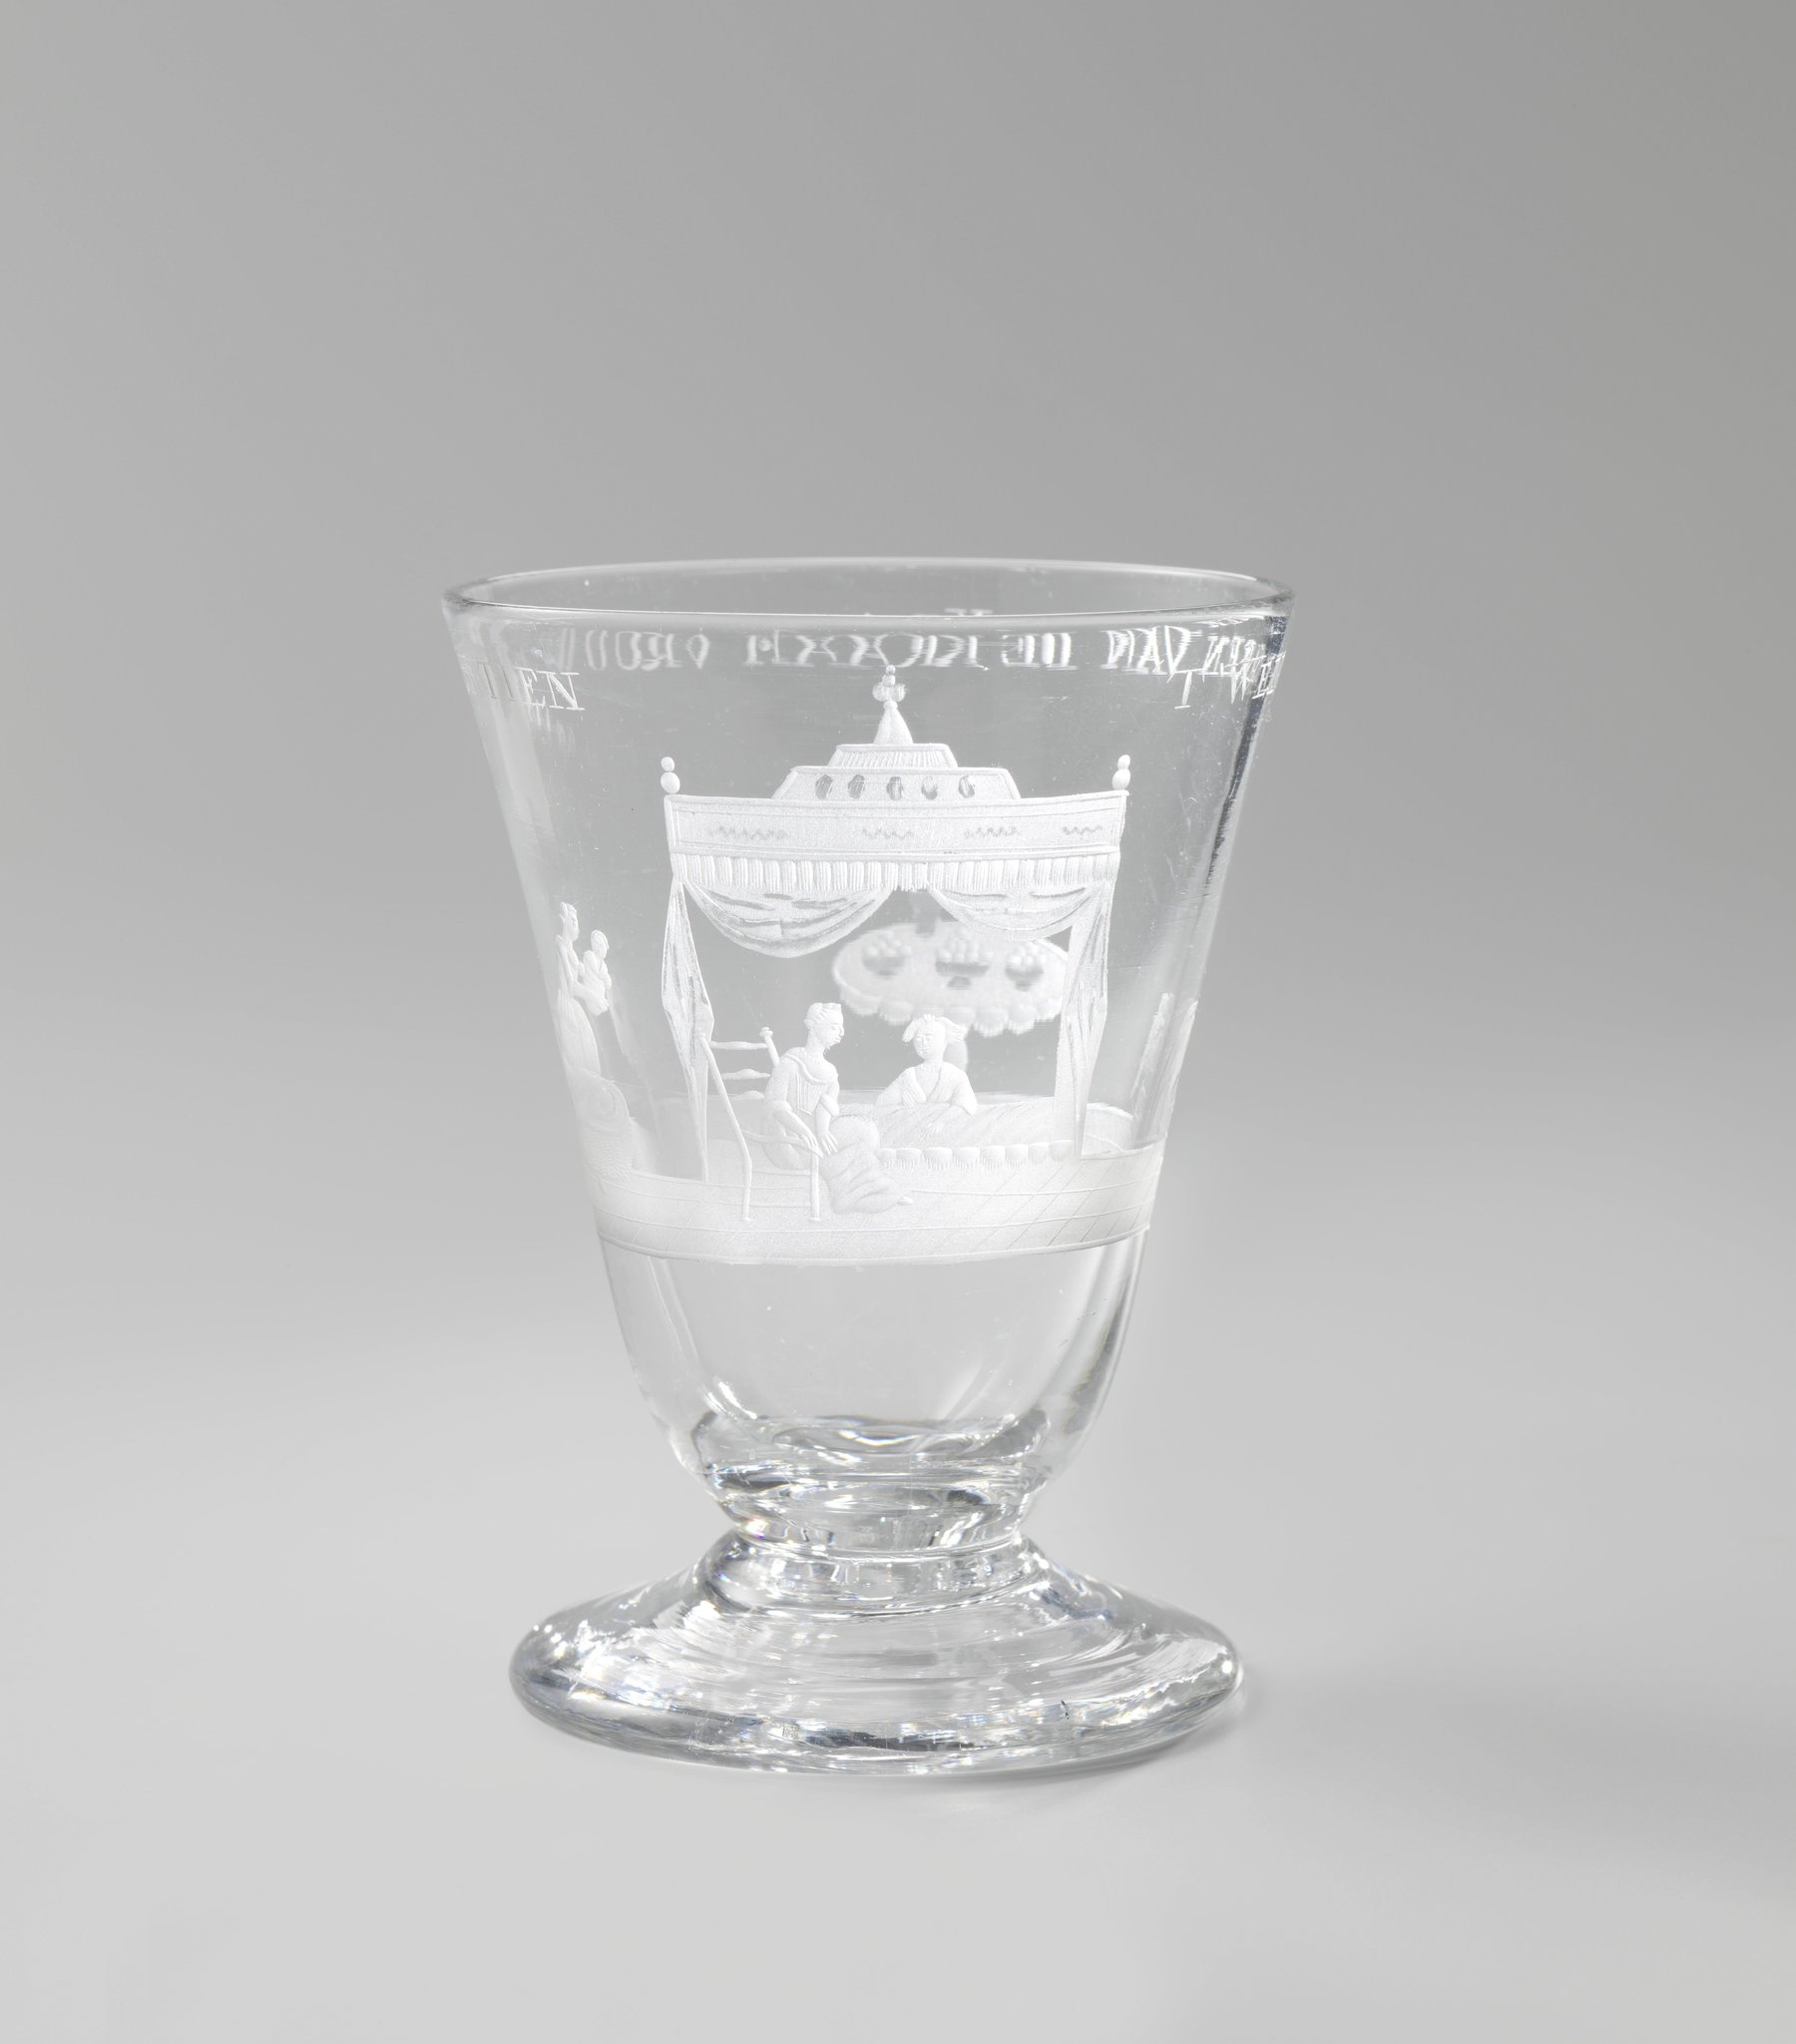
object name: goblet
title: Wine glass with a lying-in chamber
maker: Anonymous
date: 1750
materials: glass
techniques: glassblowing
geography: northern netherlands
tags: lying-in room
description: translation of inscription: the well-being of the mother and child